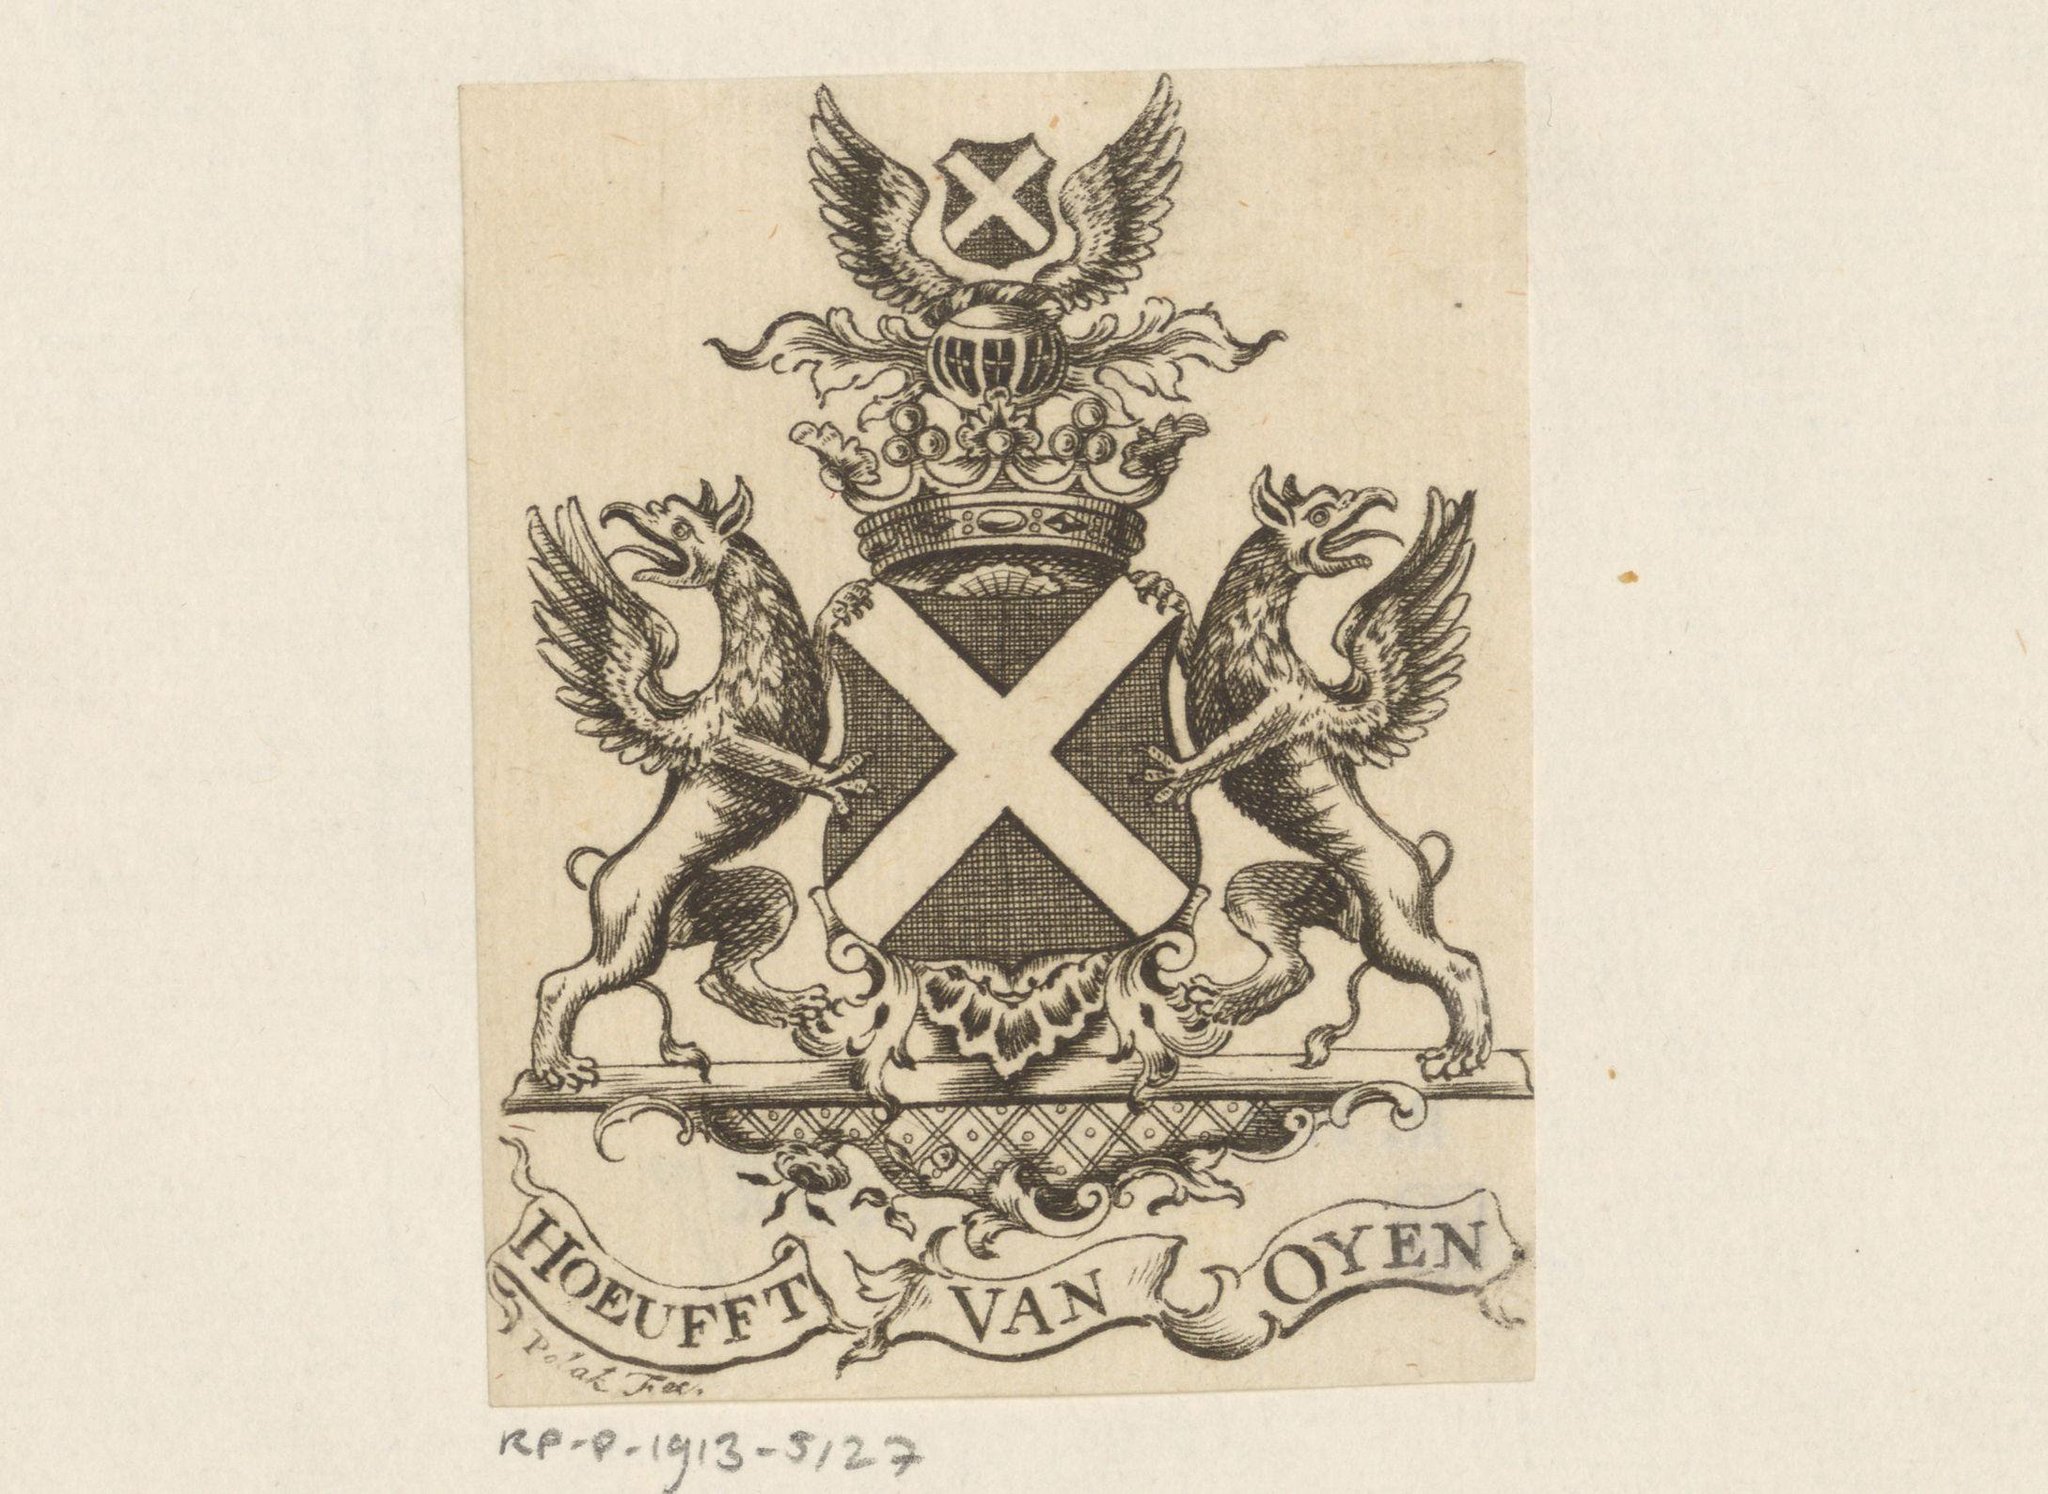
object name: bookplate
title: Ex libris van Hoeufft van Oyen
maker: abraham isack polak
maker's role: print maker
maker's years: 1720-1790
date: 1730-1790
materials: paper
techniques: etching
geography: netherlands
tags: griffin (lion/eagle); 'griffo' (ripa), armorial bearing, heraldry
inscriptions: collector's mark: Lugt 2760, collector's mark: Lugt 2233